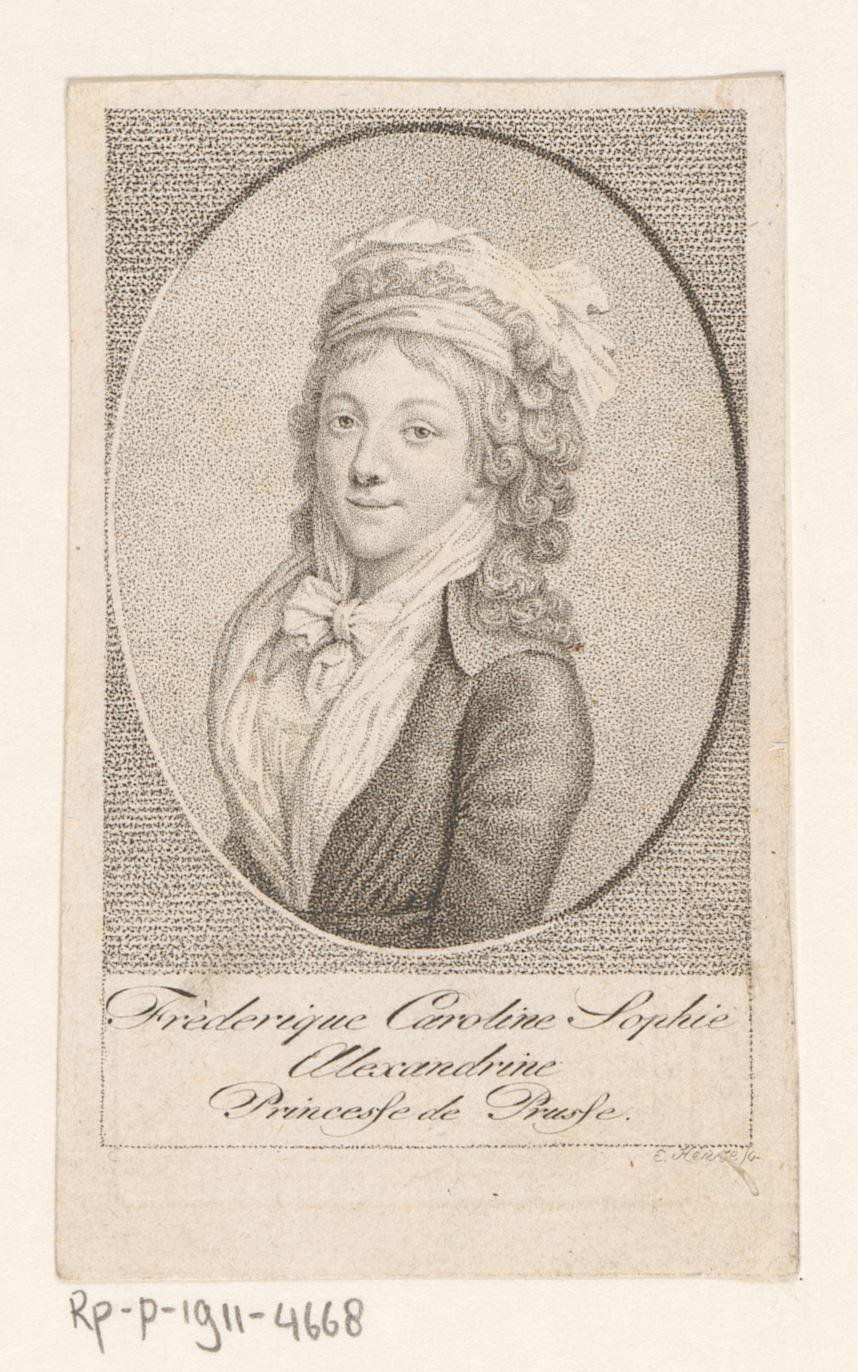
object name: print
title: Portret van Frederika von Mecklenburg-Strelitz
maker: eberhard siegfried henne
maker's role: print maker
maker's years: 1759-1828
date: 1788-1828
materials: paper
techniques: stippling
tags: historical persons - bb - woman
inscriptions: collector's mark: Lugt 2228